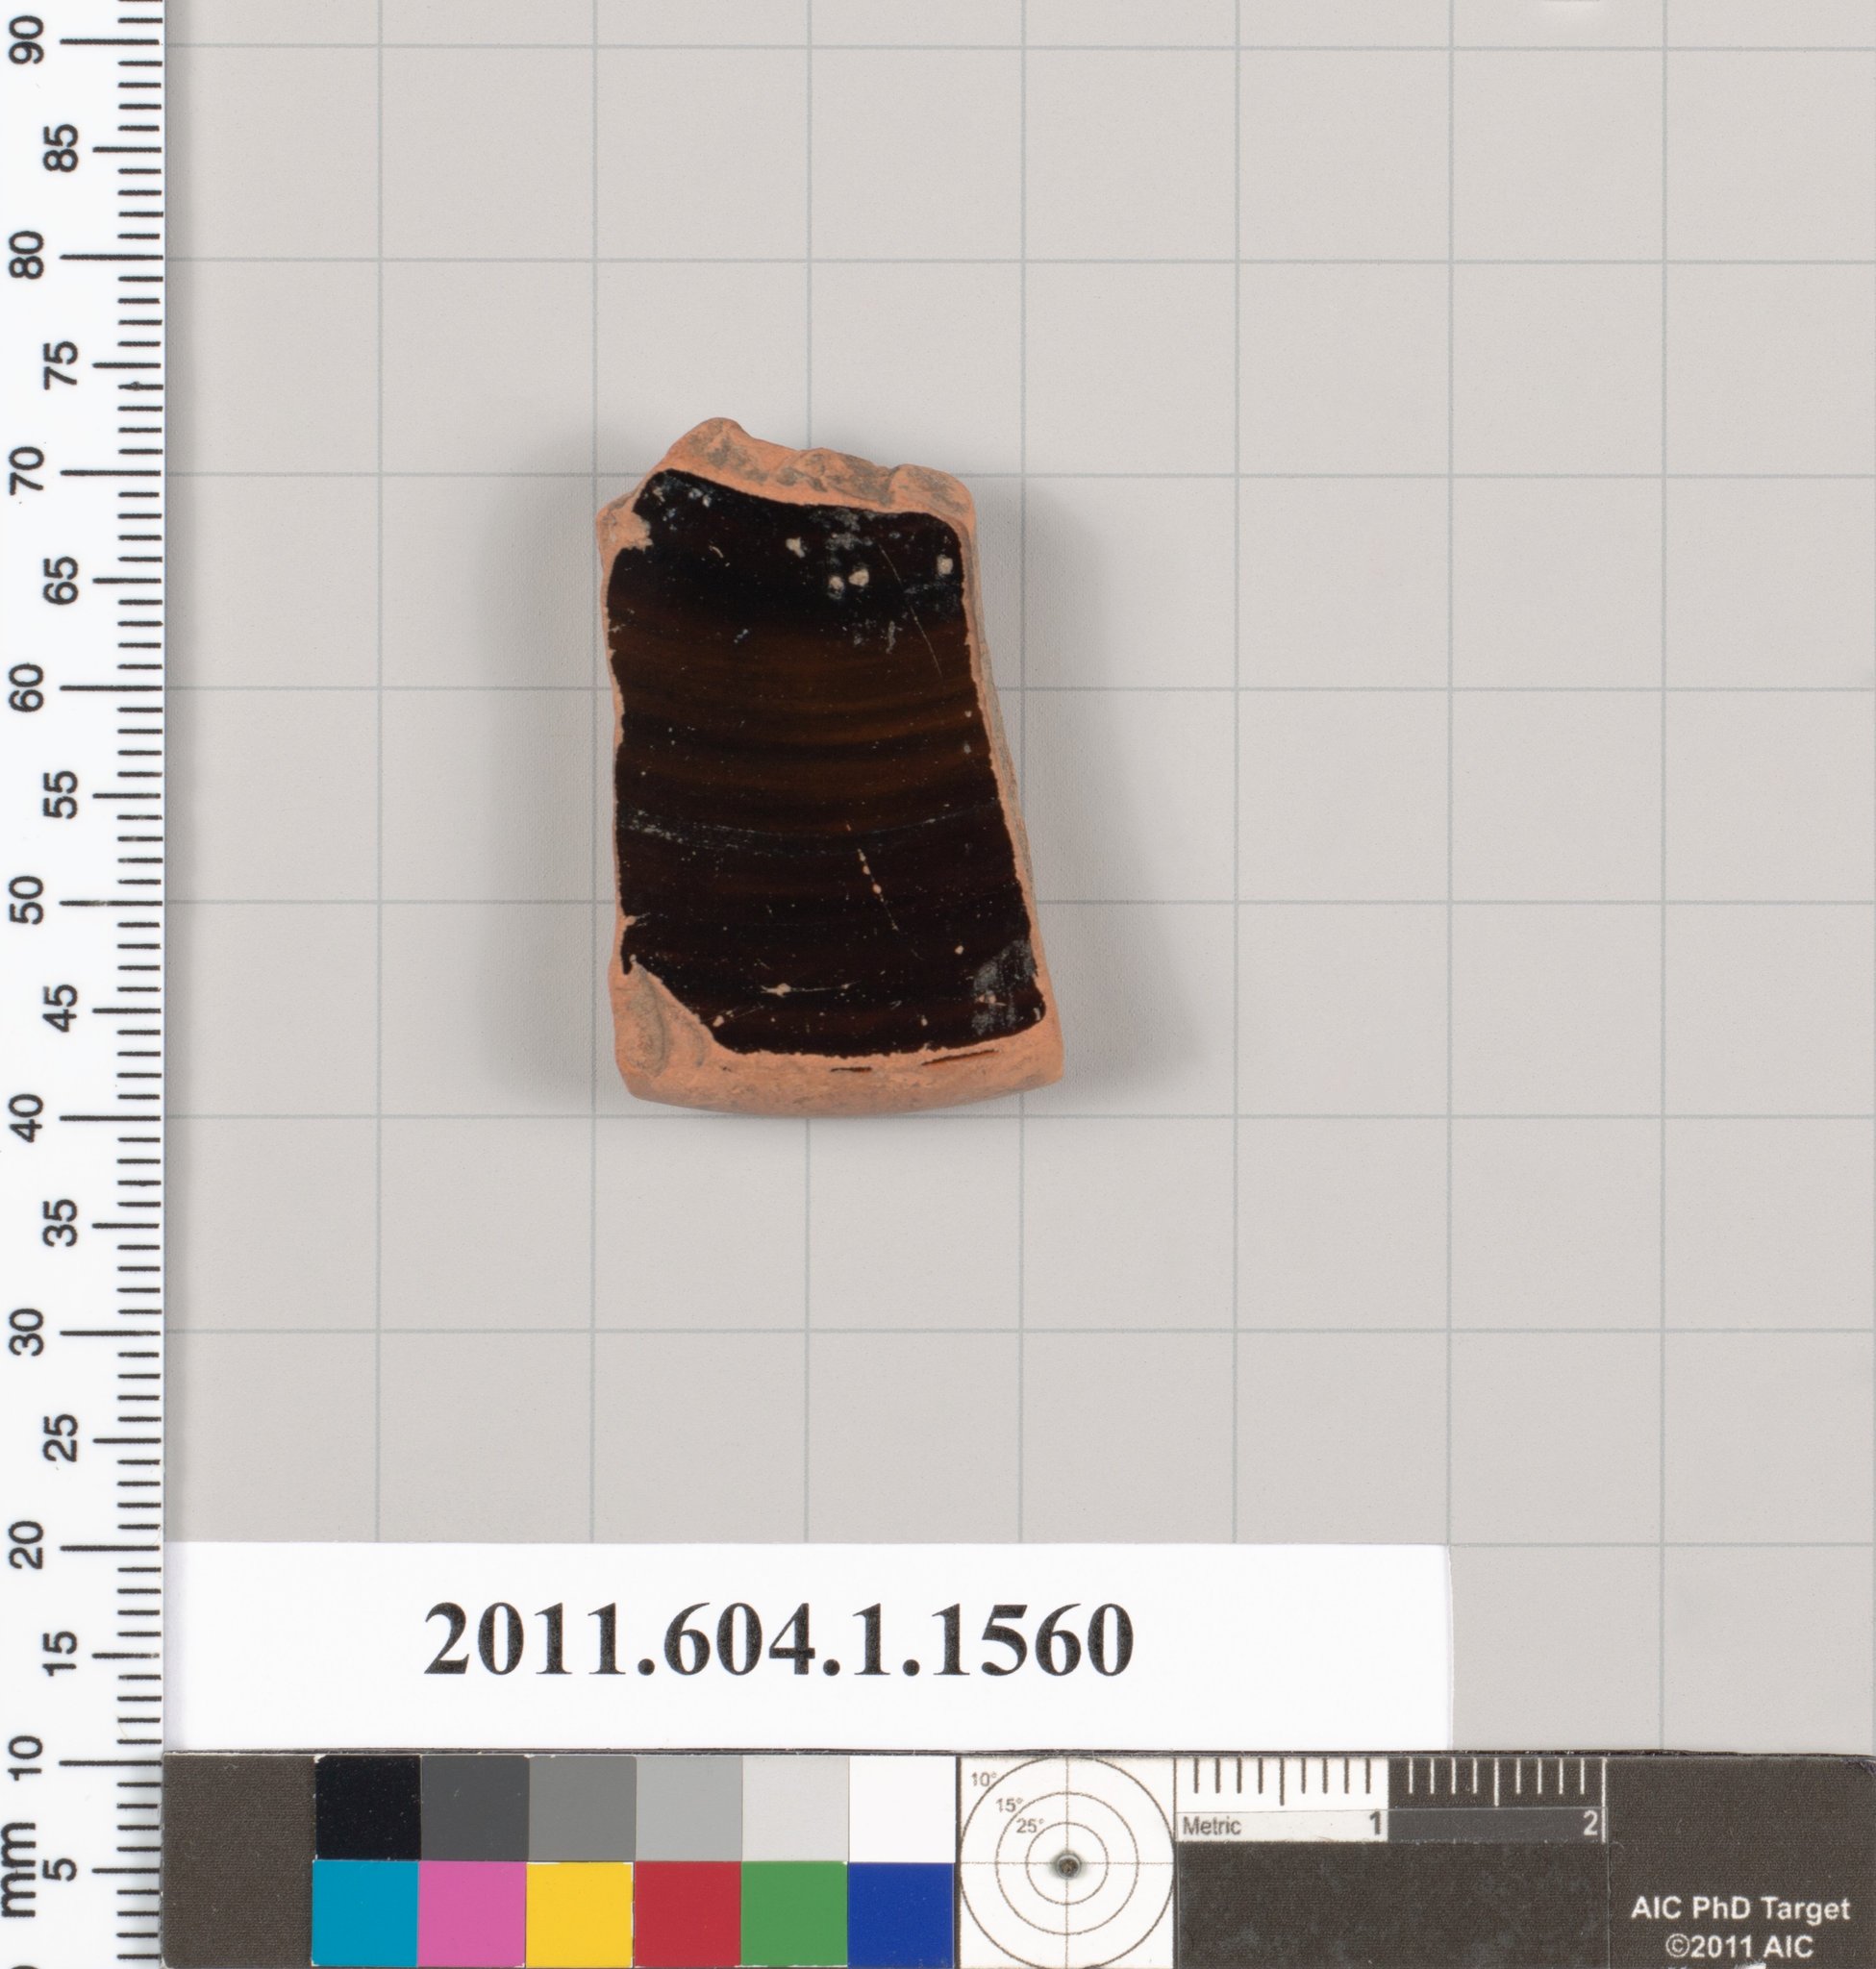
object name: kylix fragment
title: Terracotta fragment of a kylix (drinking cup)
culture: greek, attic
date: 500-401 BCE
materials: terracotta